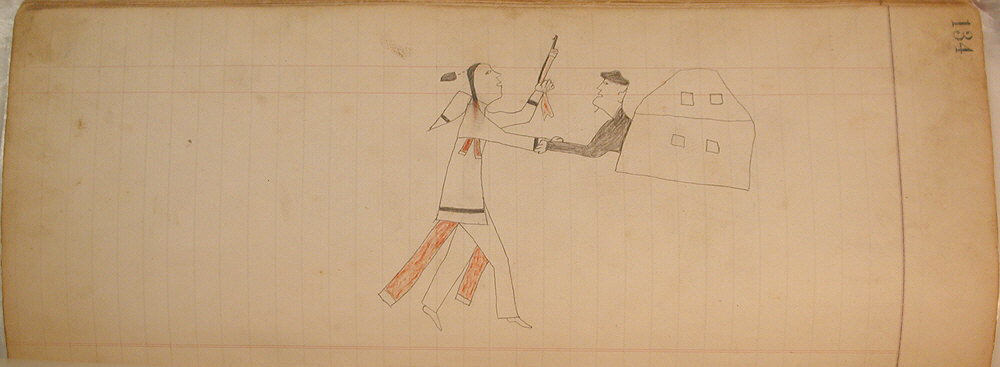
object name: drawing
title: Maffet Ledger: Drawing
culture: cheyenne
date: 1874-1881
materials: crayon, graphite, paper, watercolor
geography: united states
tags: men